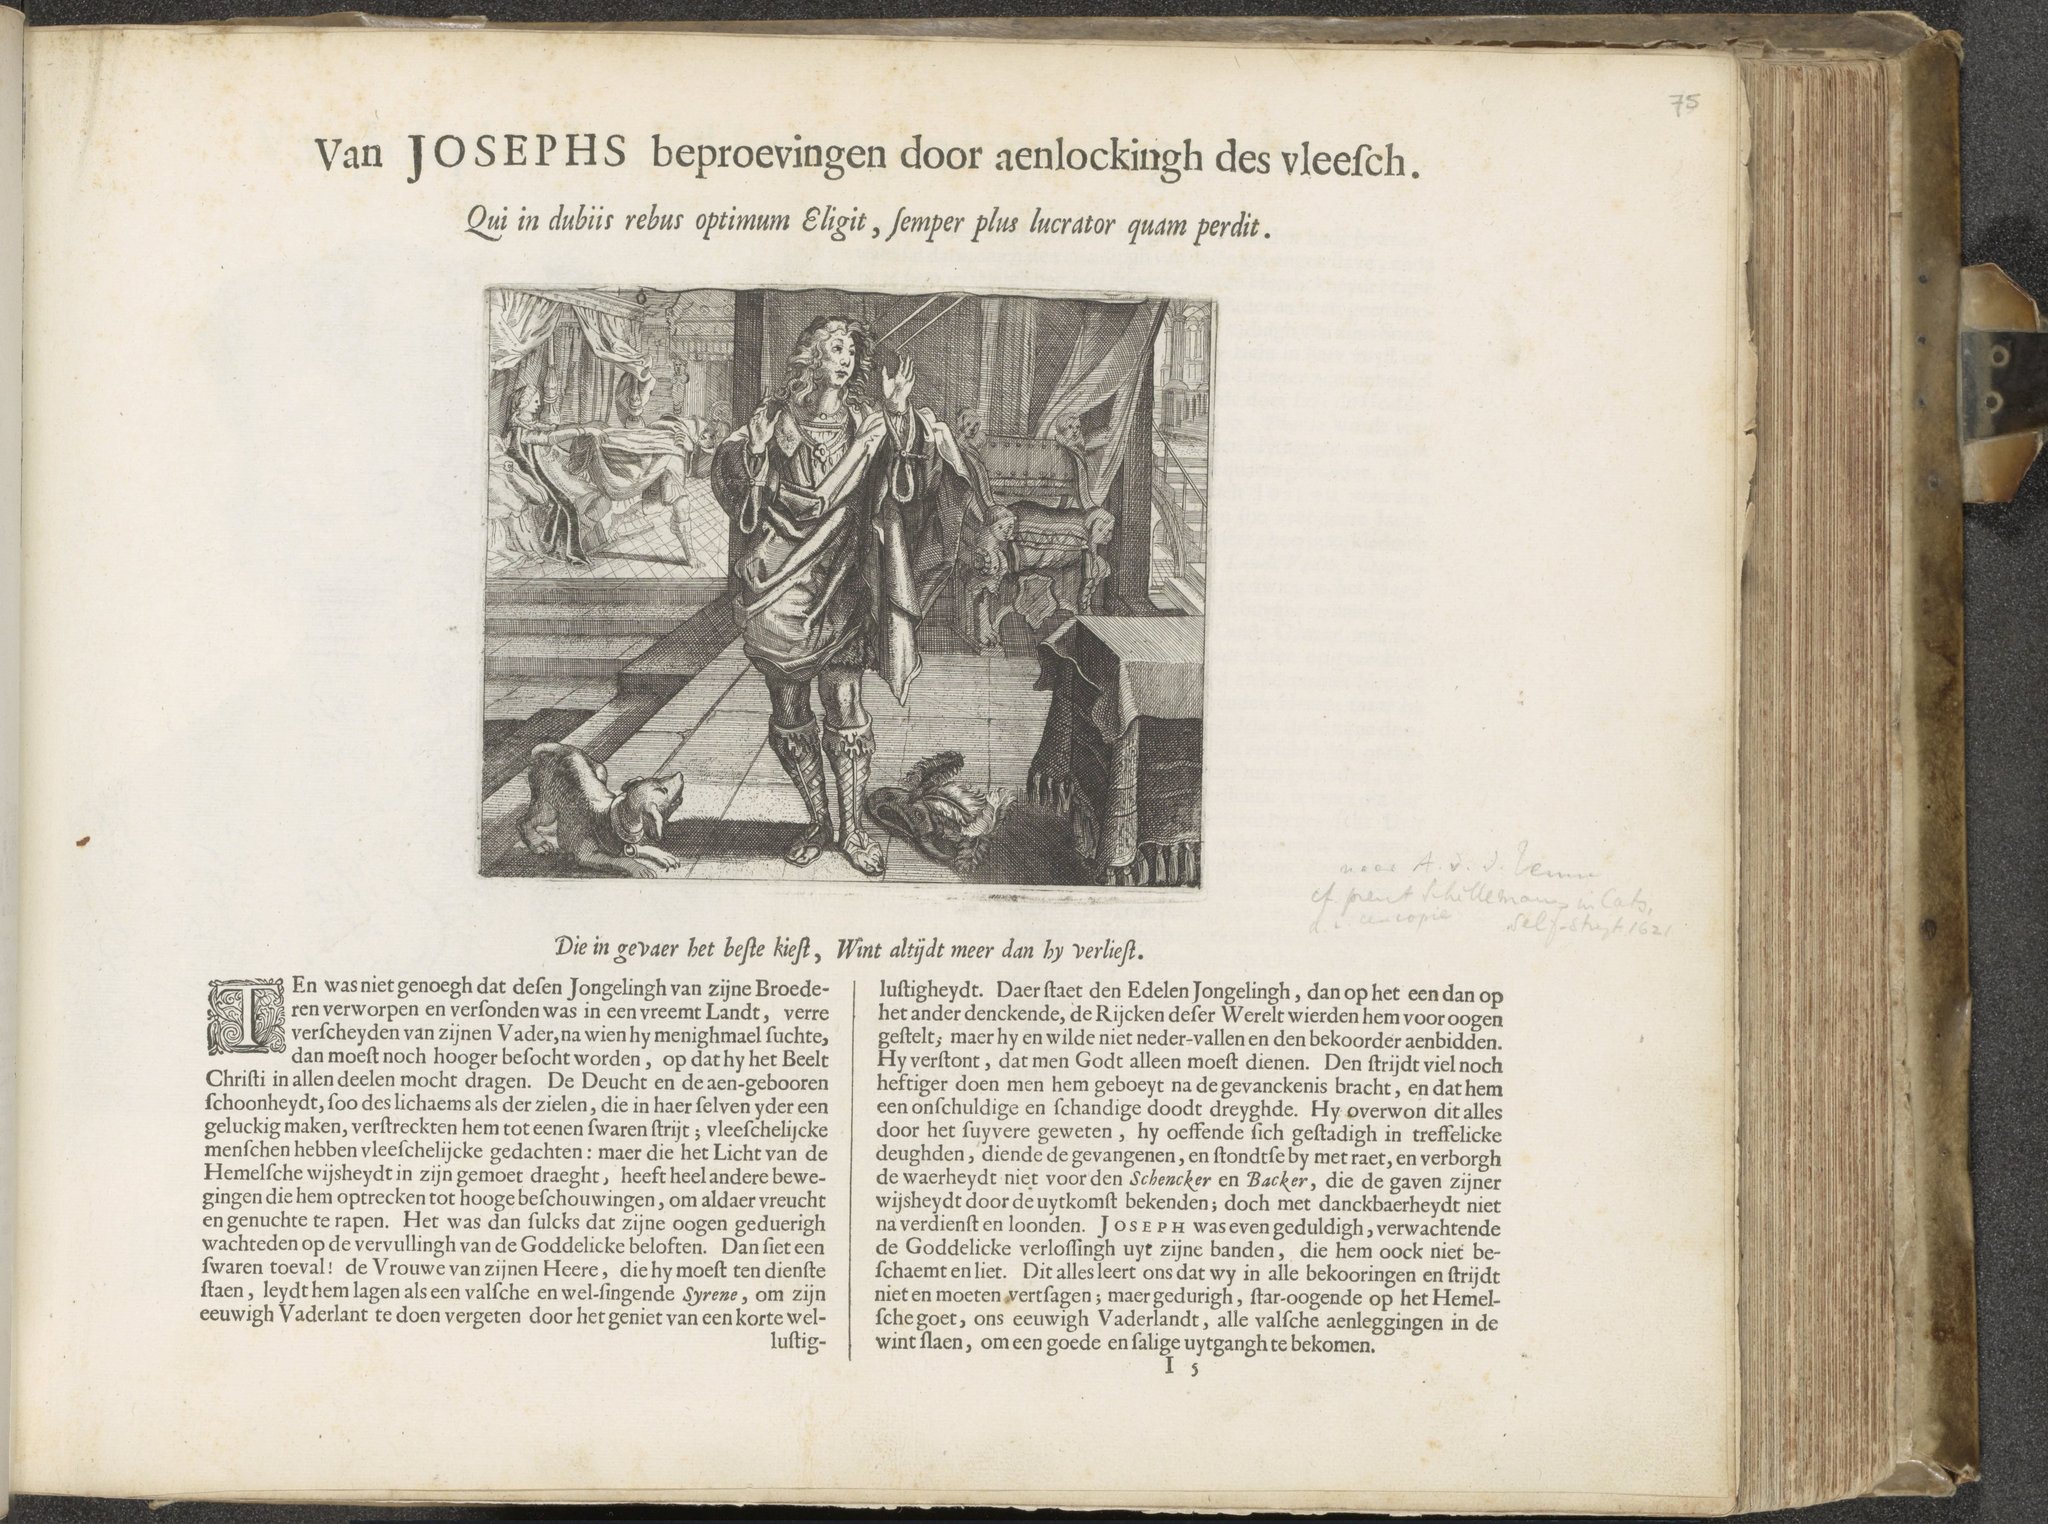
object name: print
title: Jozef en de vrouw van Potifar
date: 1620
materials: paper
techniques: etching, letterpress printing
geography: amsterdam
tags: potiphar's wife catches joseph by his robe, usually while lying in bed; joseph escapes leaving his cloak behind in her hands (possibly with a naked child lying in a crib), interior of the house, joseph in potiphar's house; the chastity of joseph (genesis 37:36, 39:1-20)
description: Jozef staande in een interieur. Zijn hoed ligt naast hem op de grond. Links een hond. Op de achtergrond het slaapvertrek waar Jozef wegrent van de vrouw van Potifar. Zij pakt zijn mantel beet. De begeleidende tekst begint met een kleine gedecoreerde initiaal T. Daarbij een motto in het Latijn en het Nederlands: die in gevaer het beste kiest, wint altijdt meer dan hy verliest. Het blad maakt deel uit van een album.